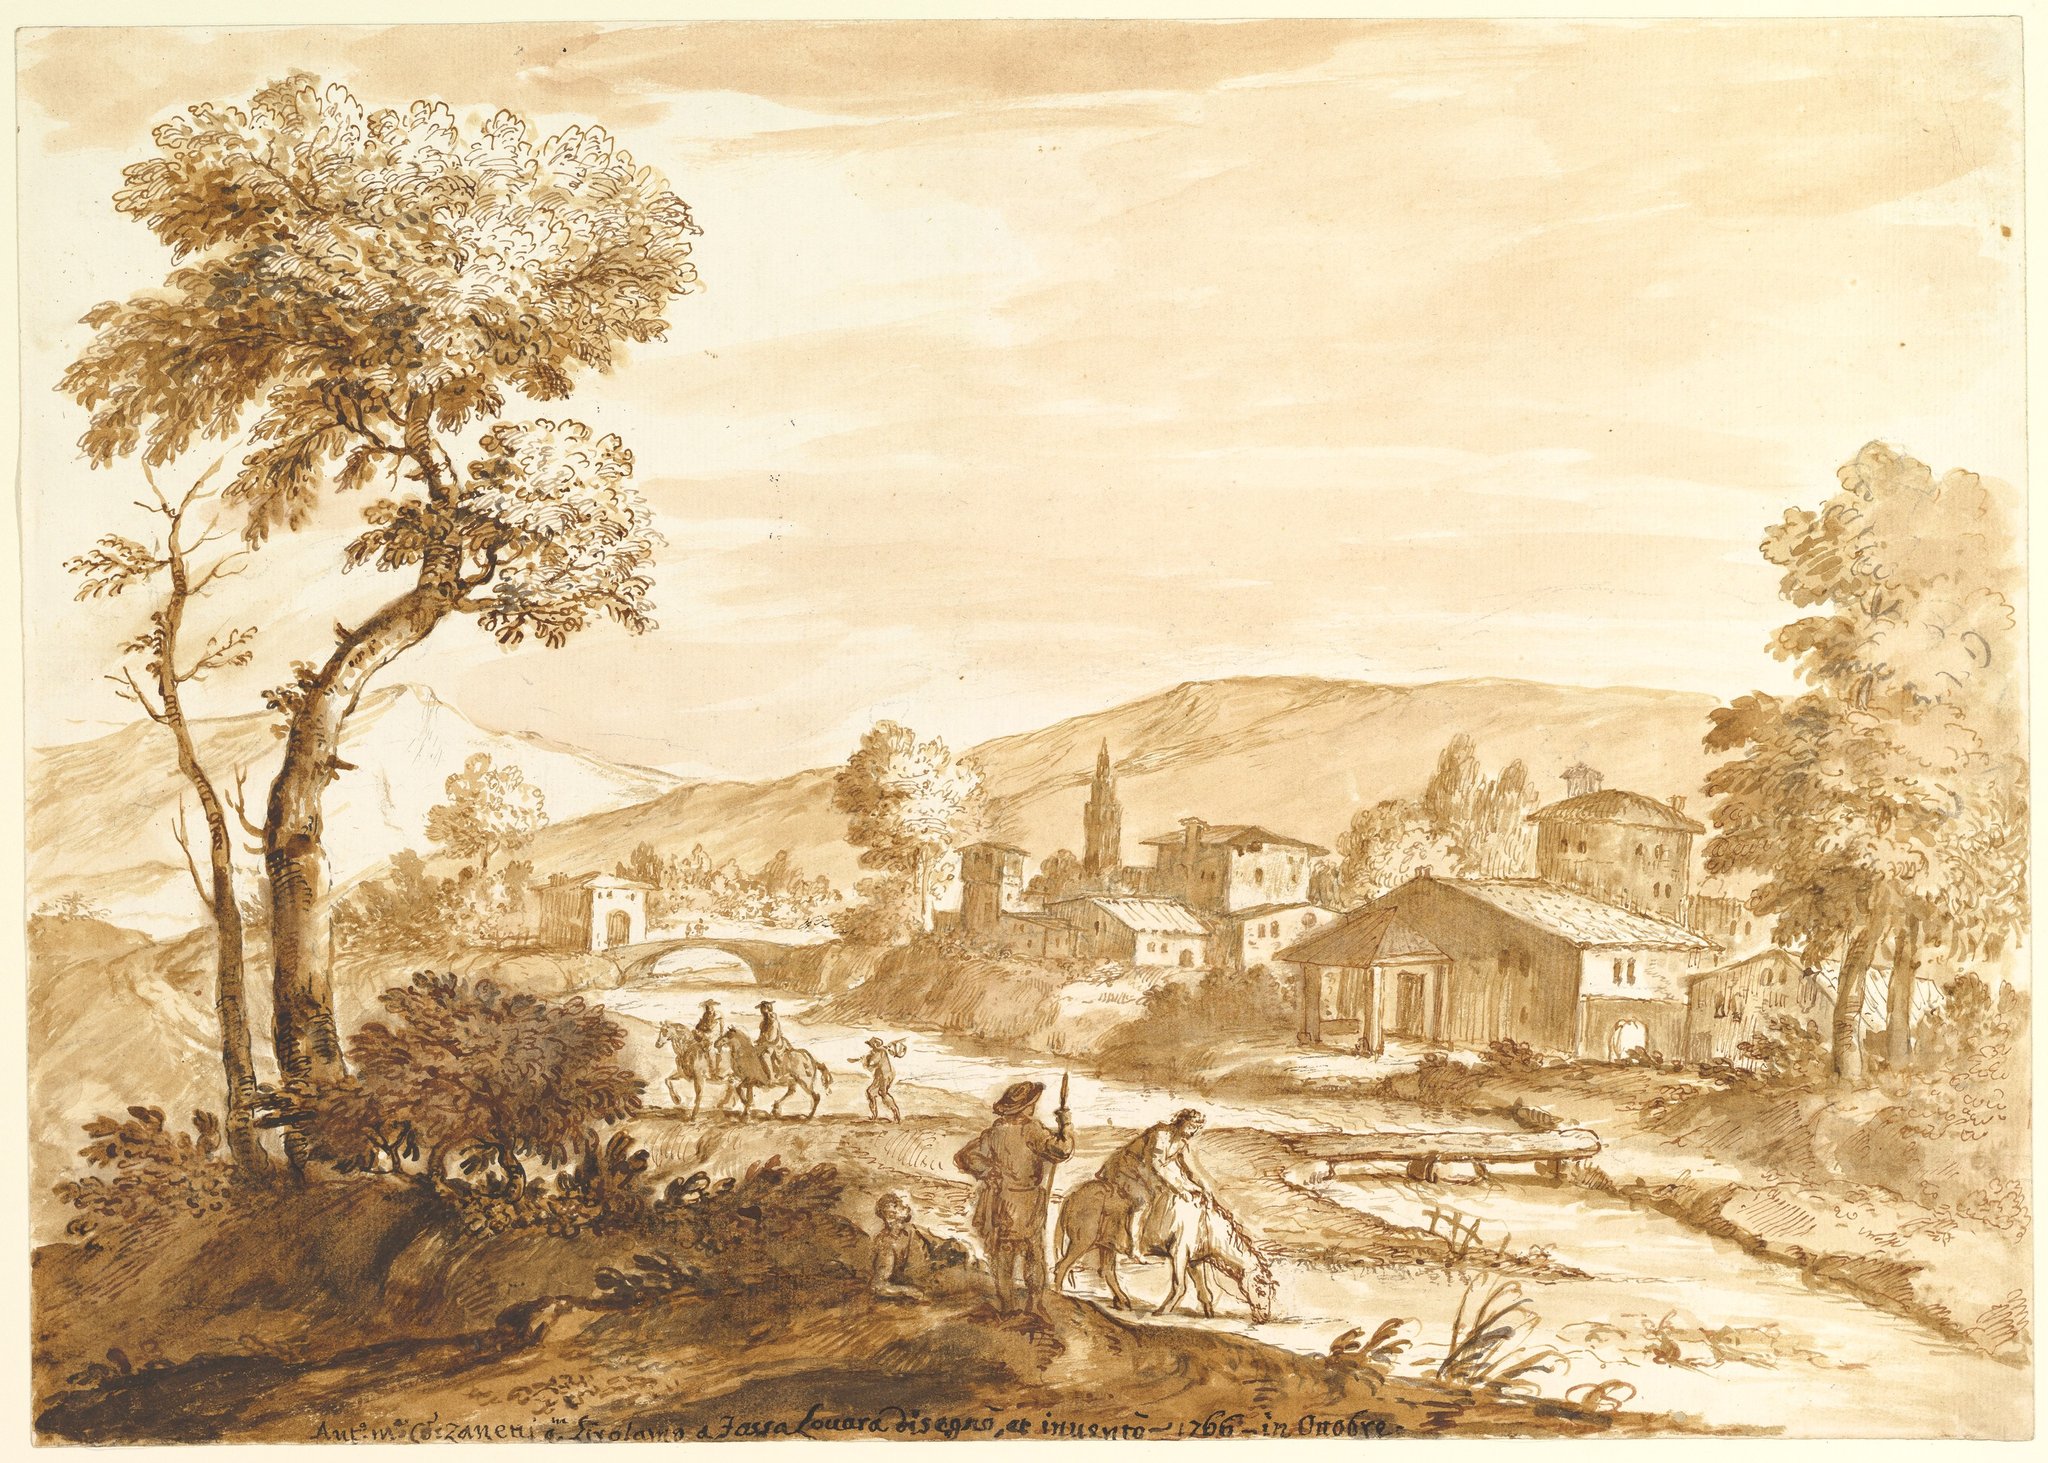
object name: drawing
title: Landscape with a Town by a River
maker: conte anton maria zanetti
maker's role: artist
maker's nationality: italian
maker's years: 1680-1767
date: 1680-1767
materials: graphite, ink, lead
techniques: brush, pen, wash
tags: houses,men,horses,rivers,landscapes